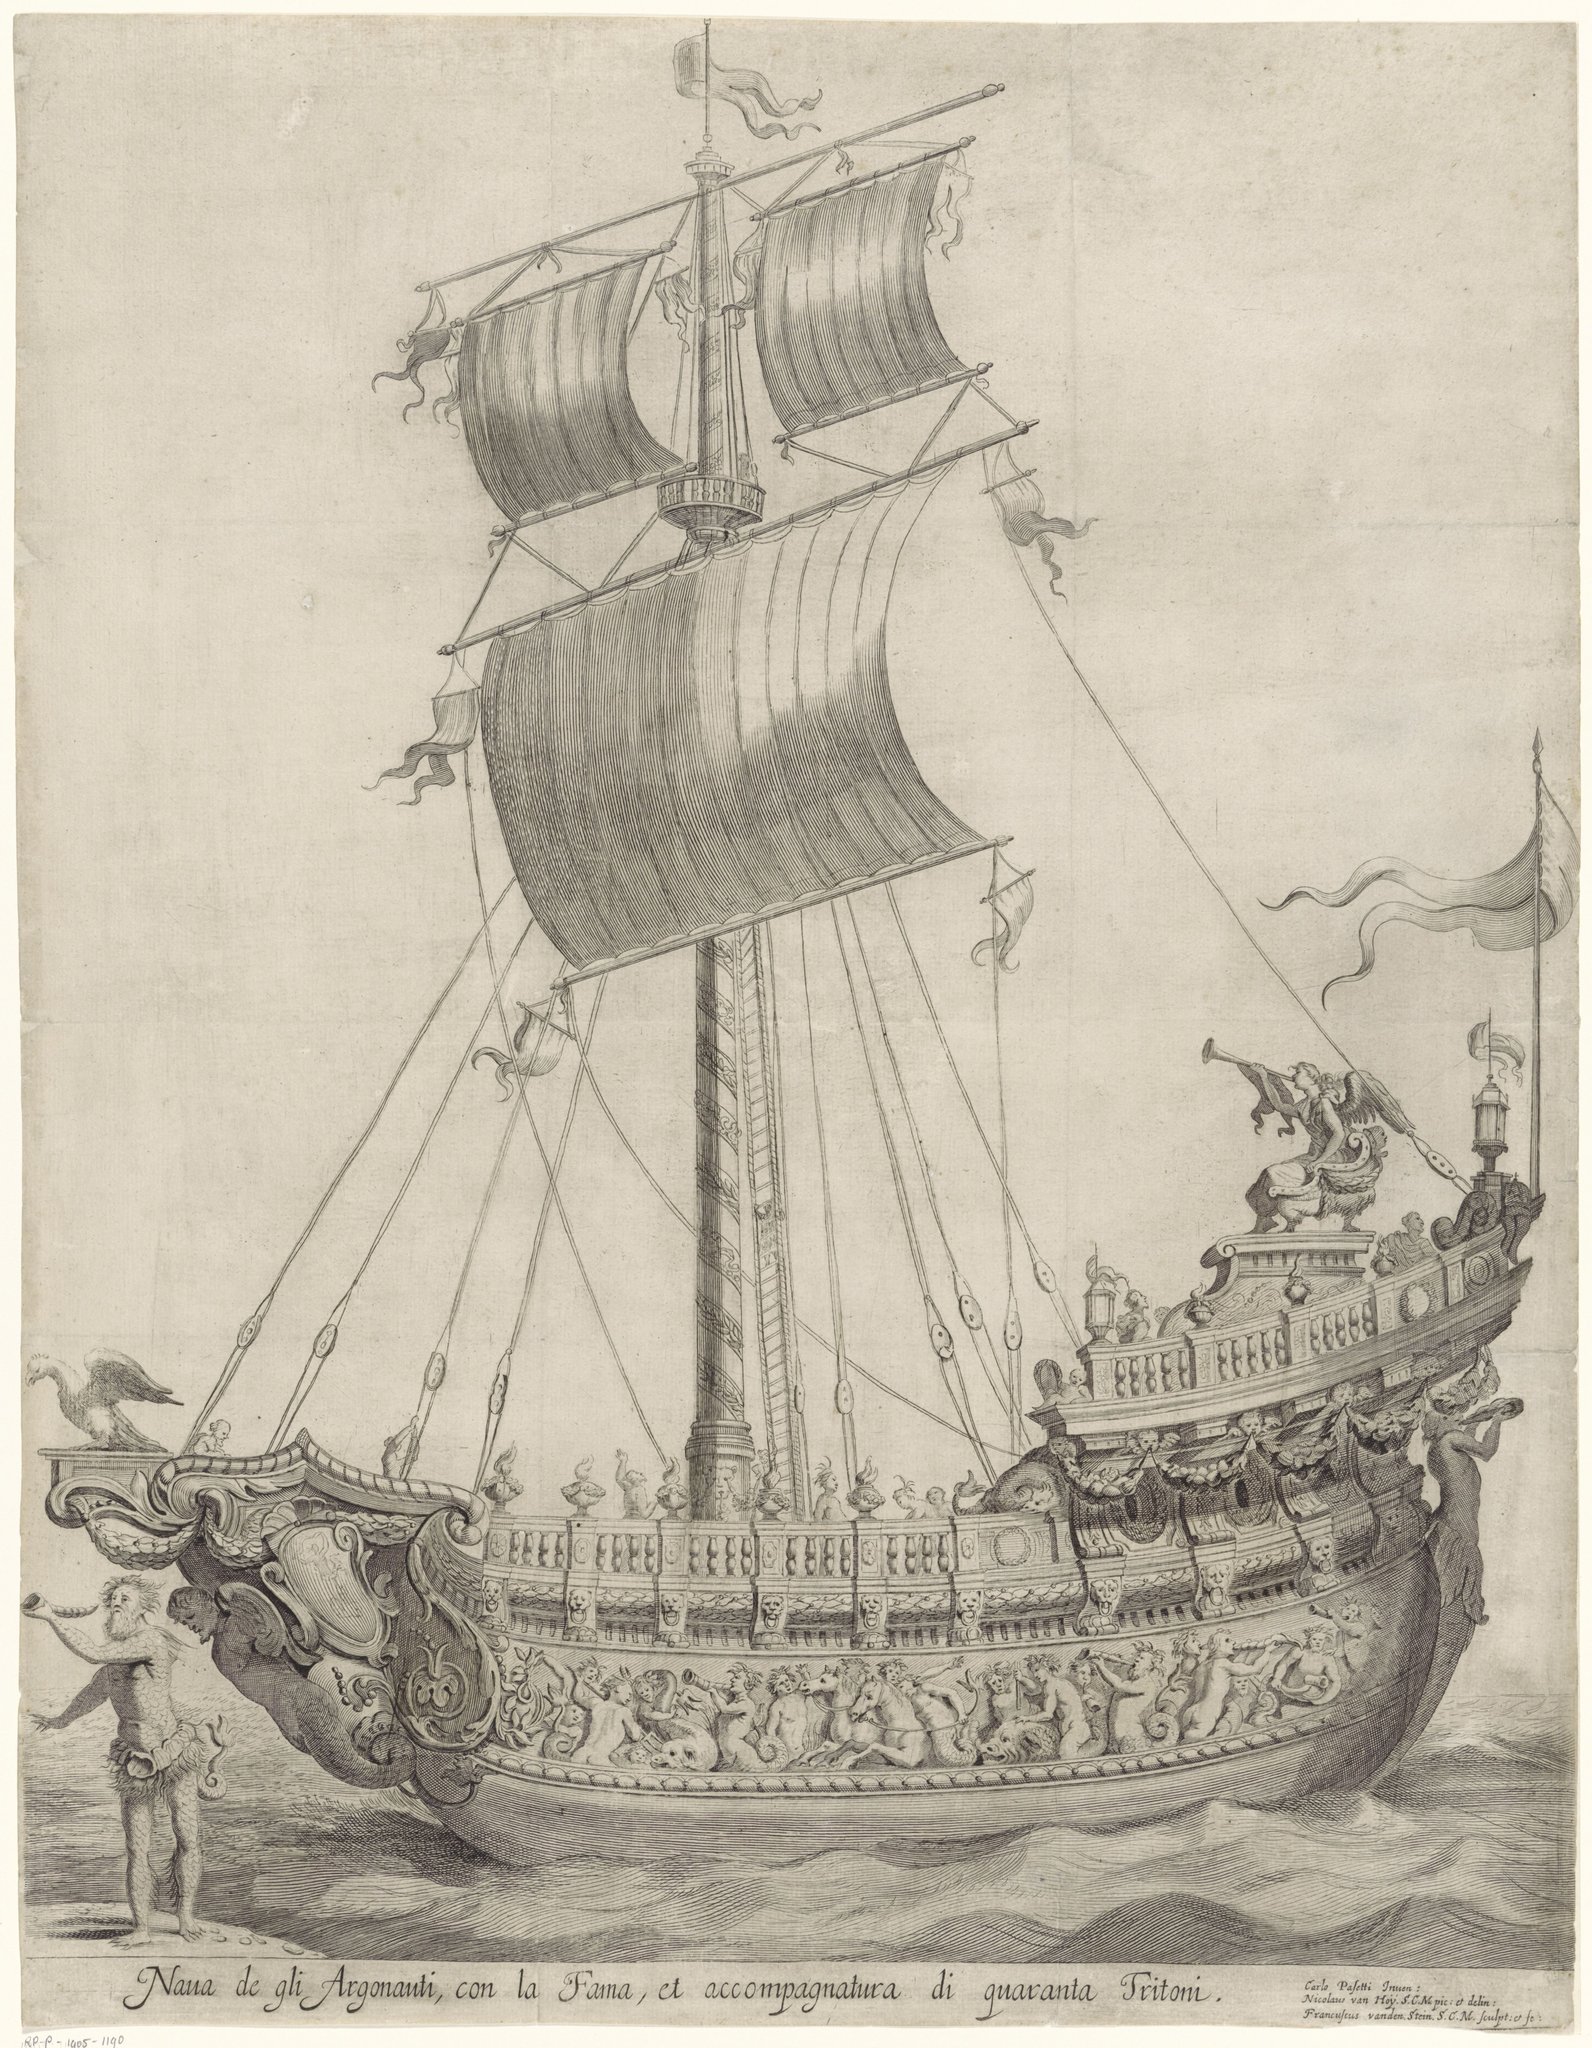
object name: book illustration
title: Schip van de Argonauten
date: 1667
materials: paper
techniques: engraving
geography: vienna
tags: the story of the argonauts: the quest for the golden fleece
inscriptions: collector's mark: Lugt 2228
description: Het door Carlo Pasetti ontworpen schip dat werd getoond bij de feestelijke viering van het huwelijk van Leopold I en Margaretha Theresia van Spanje in 1667 te Wenen. Het schip stelt Argo, het schip van de Argonauten voor. Faam zit hoog op het achterdek en blaast haar trompet. De zijkant van het schip is versiert met tritons.